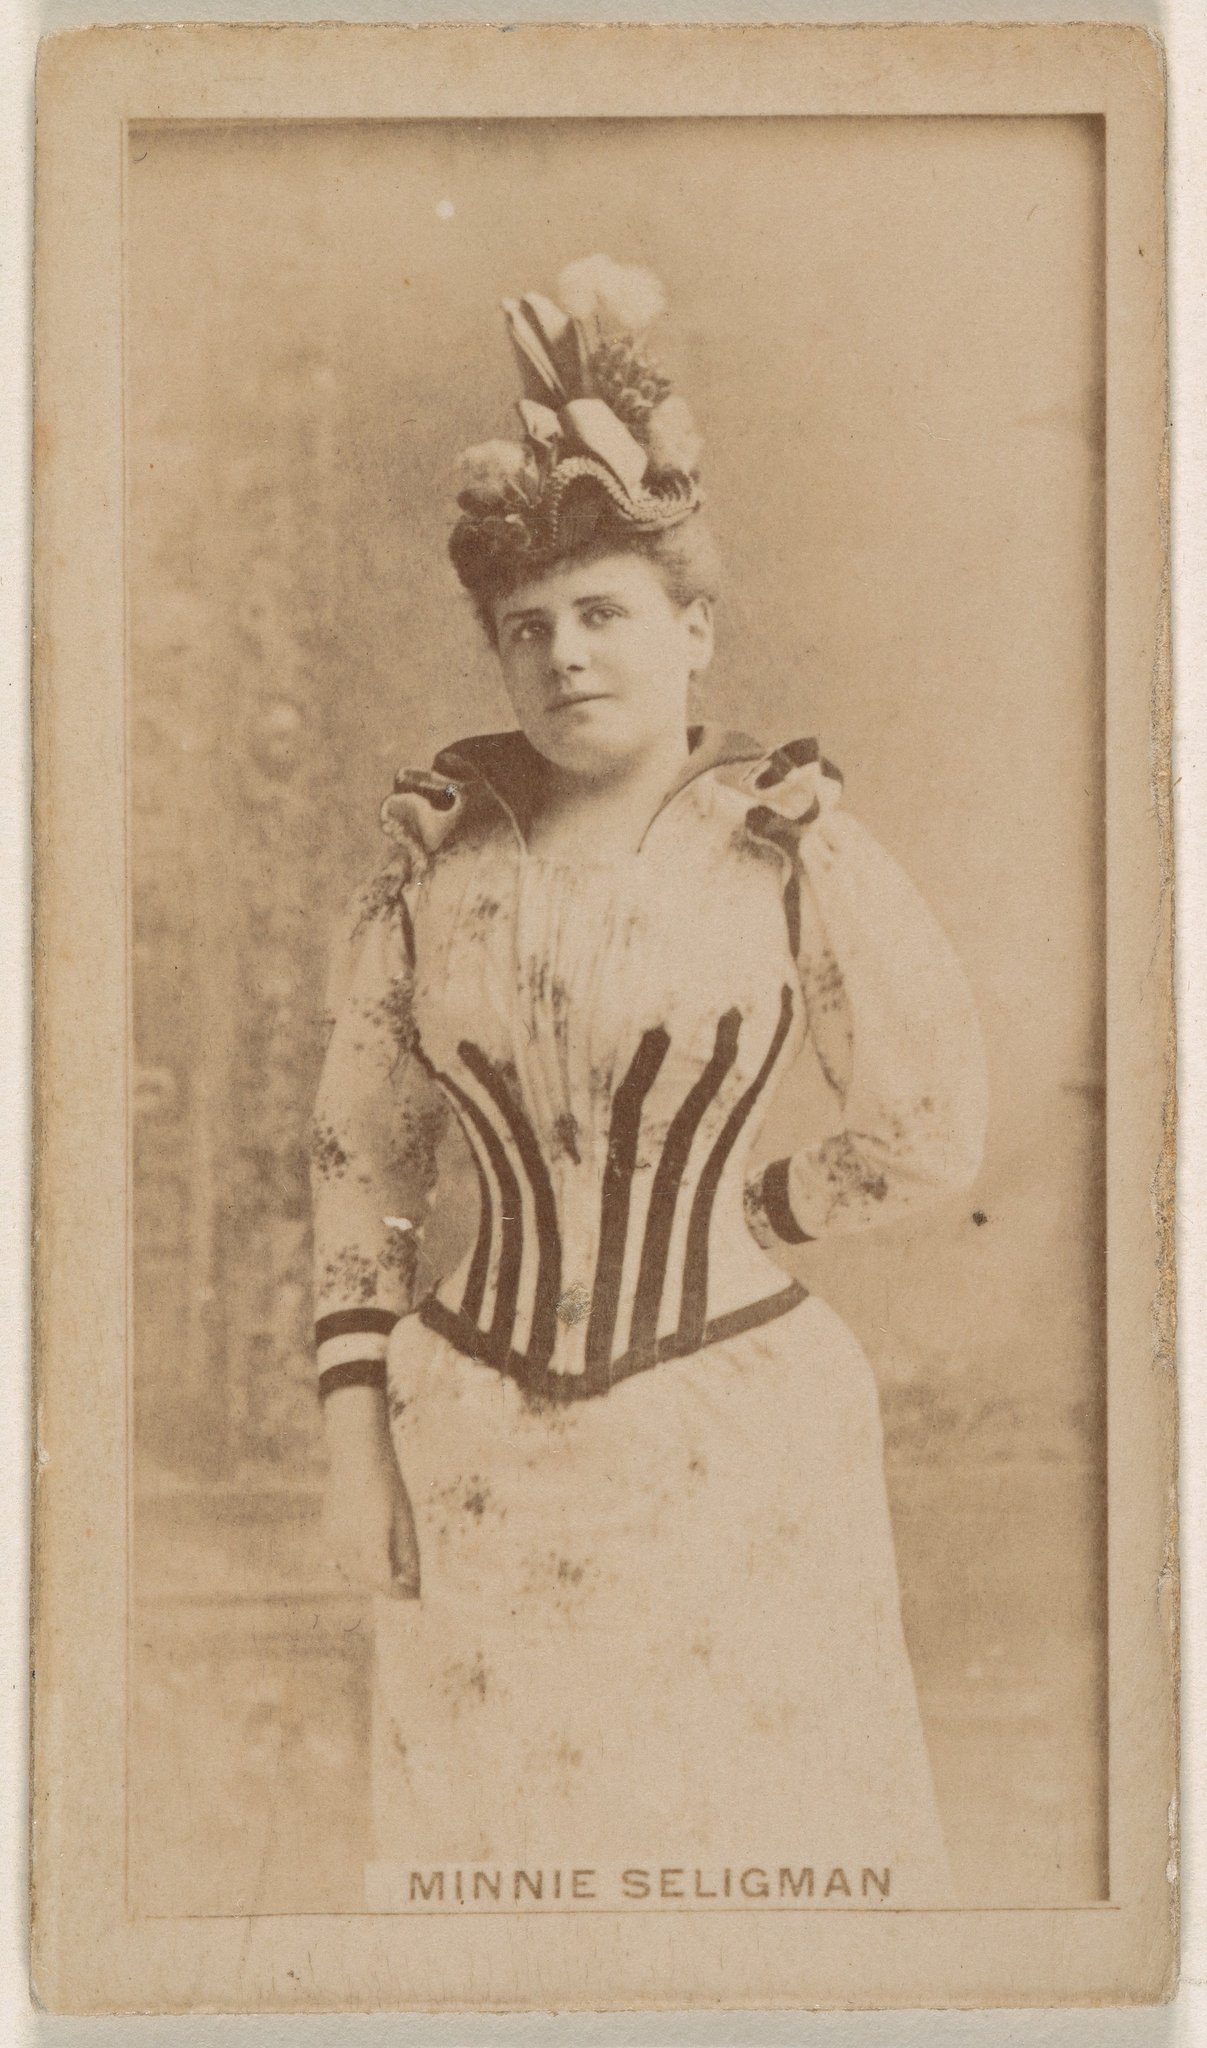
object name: photograph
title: Minnie Seligman, from the Actresses series (N245) issued by Kinney Brothers to promote Sweet Caporal Cigarettes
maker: kinney brothers tobacco company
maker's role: publisher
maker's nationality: american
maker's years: 1869-2011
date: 1890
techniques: albumen silver print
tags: portraits,women,actresses